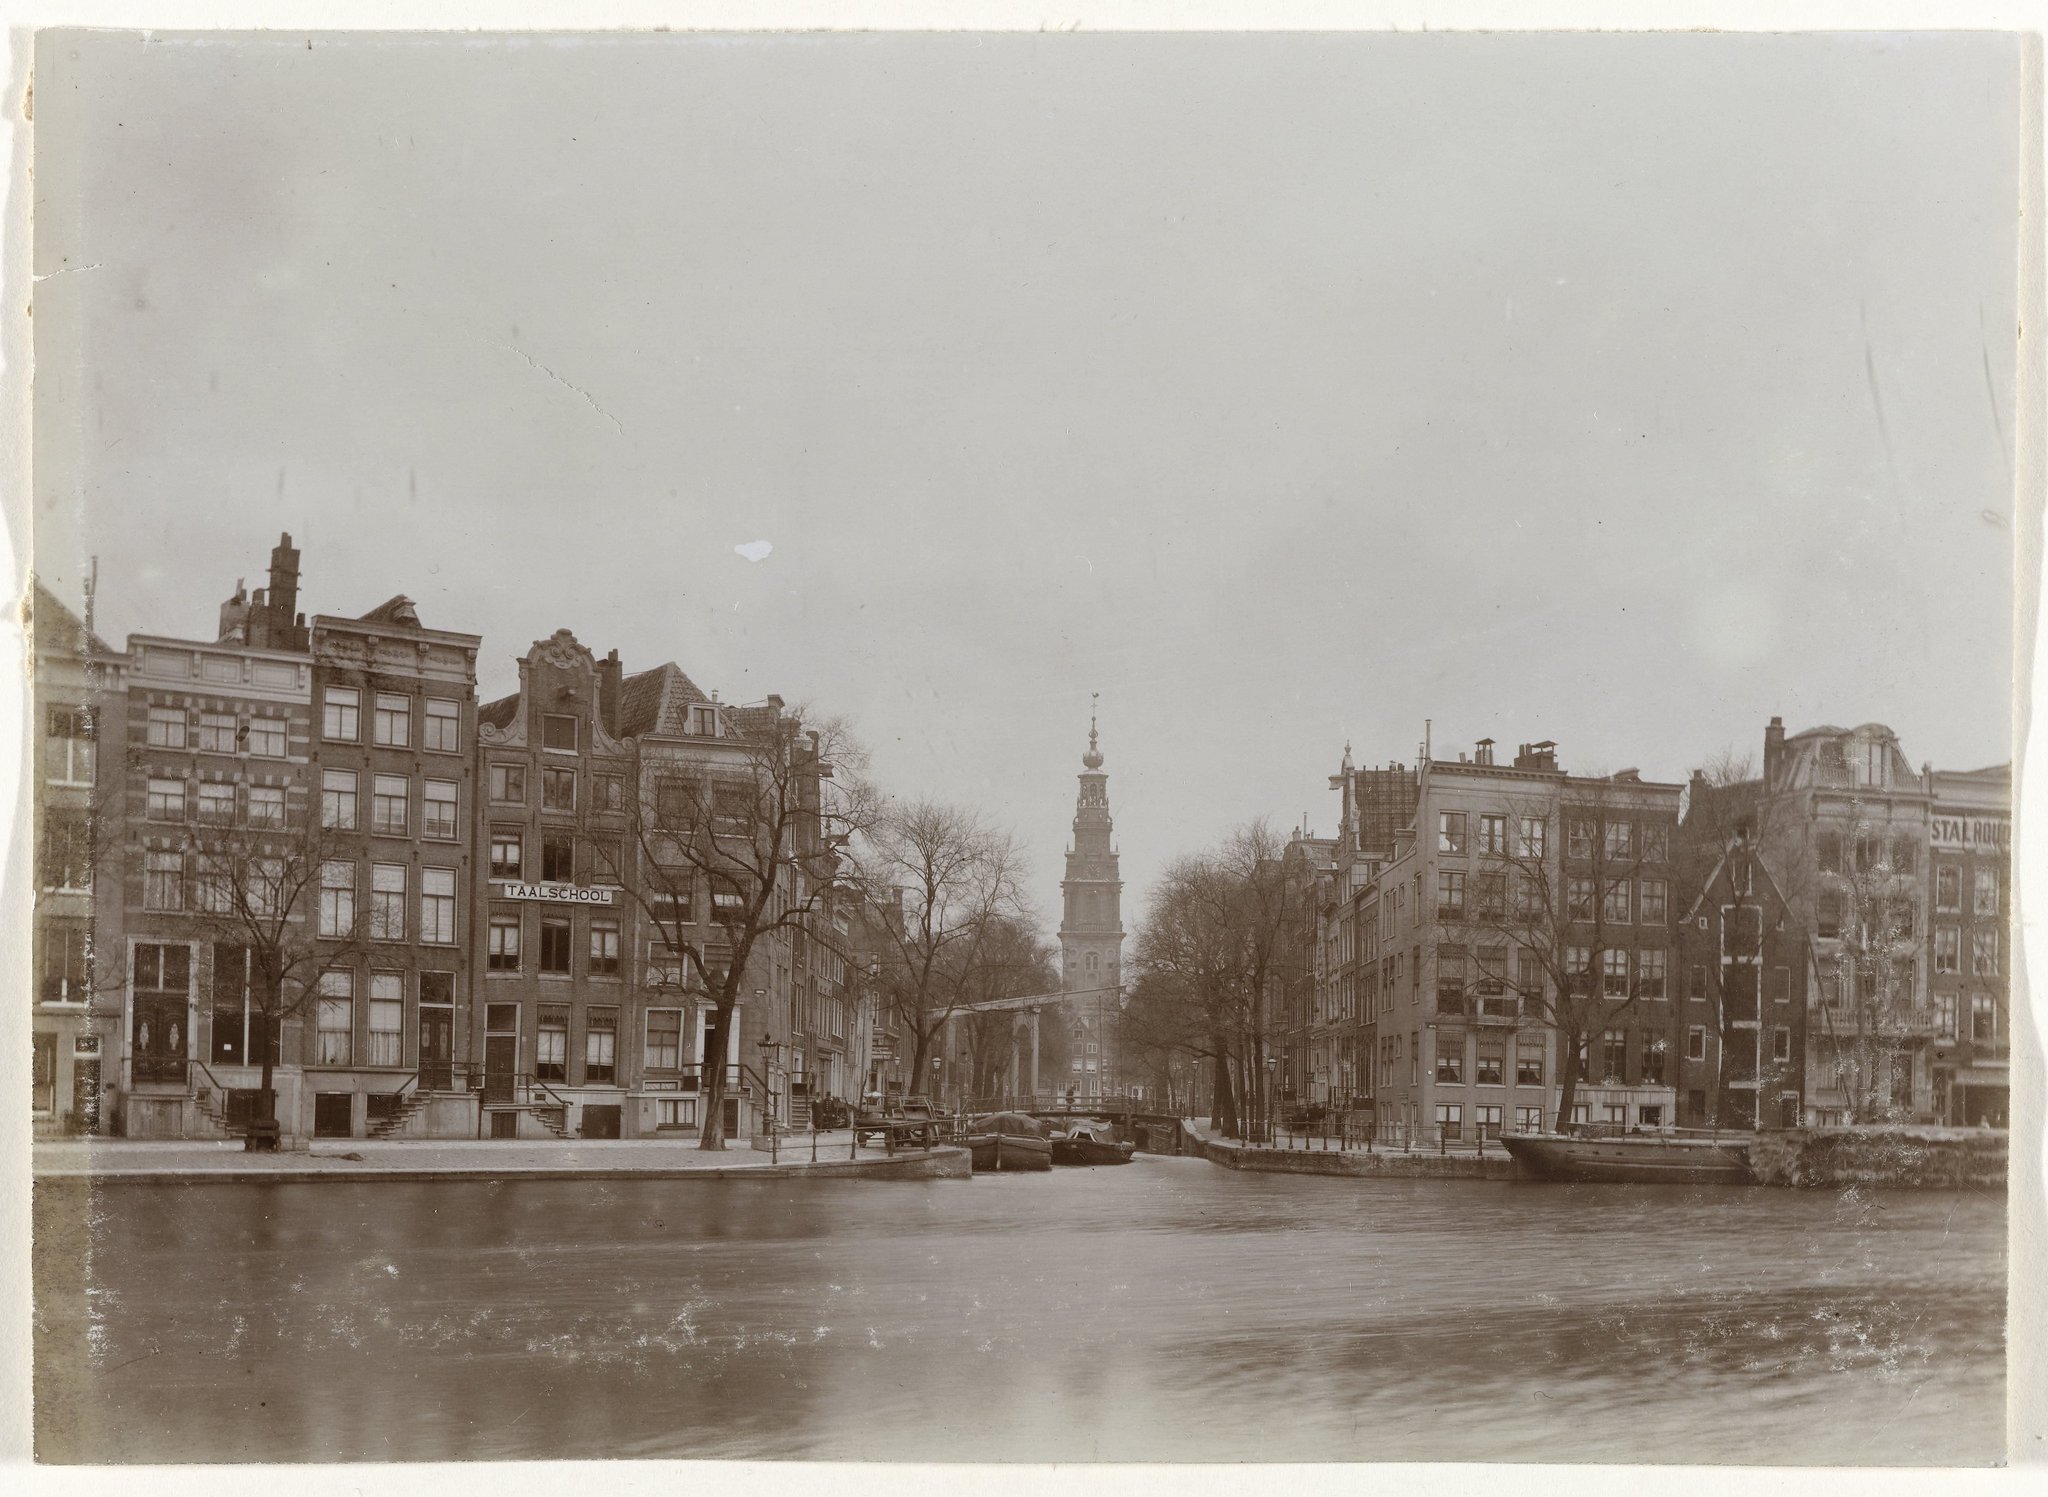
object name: photograph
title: Gezicht over de Amstel naar de Groenburgwal en de Zuiderkerk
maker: Anonymous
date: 1900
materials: paper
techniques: collodion silver print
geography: amsterdam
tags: canals, waters (in city), parts of church exterior and annexes: tower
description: Gezicht over de Amstel naar de Groenburgwal en de Zuiderkerk, links het 's Gravelandse Veer en rechts de Staalkade.